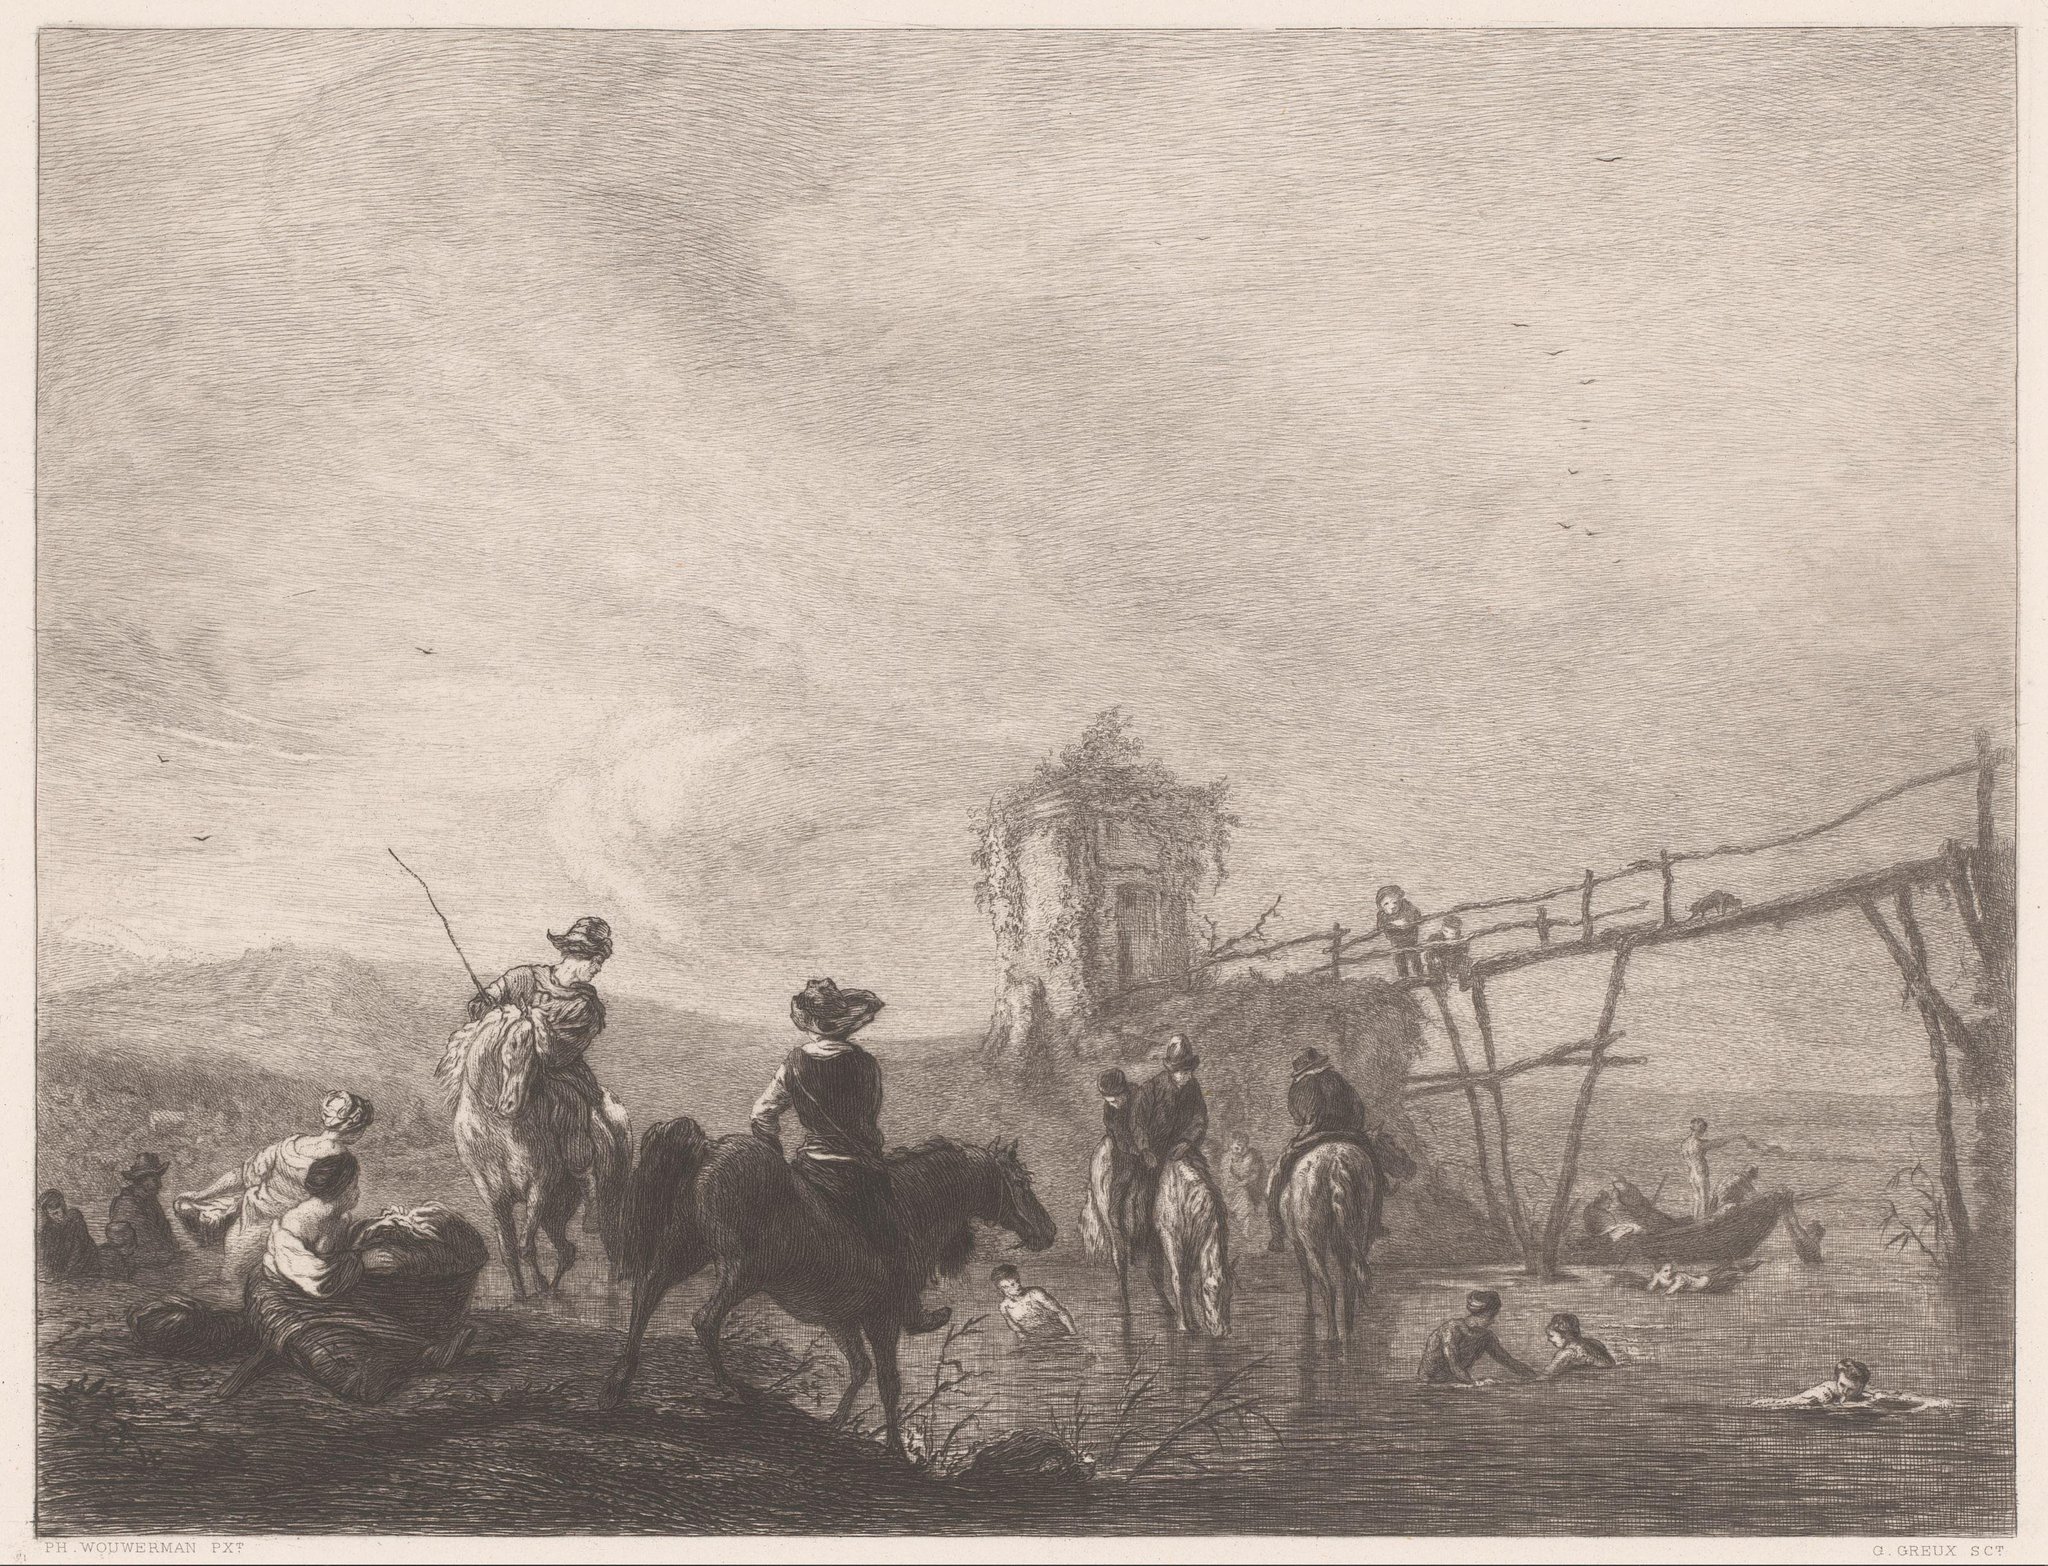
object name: print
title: Rustende en zwemmende figuren aan een oever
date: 1871-1919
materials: paper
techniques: etching, intaglio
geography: vienna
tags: landscapes with waters, waterscapes, seascapes (in the temperate zone), swimming (movement in water), giving water, feeding (cattle)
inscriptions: collector's mark: Lugt 2228, : ‘Vervielfältigung vorbehalten.’